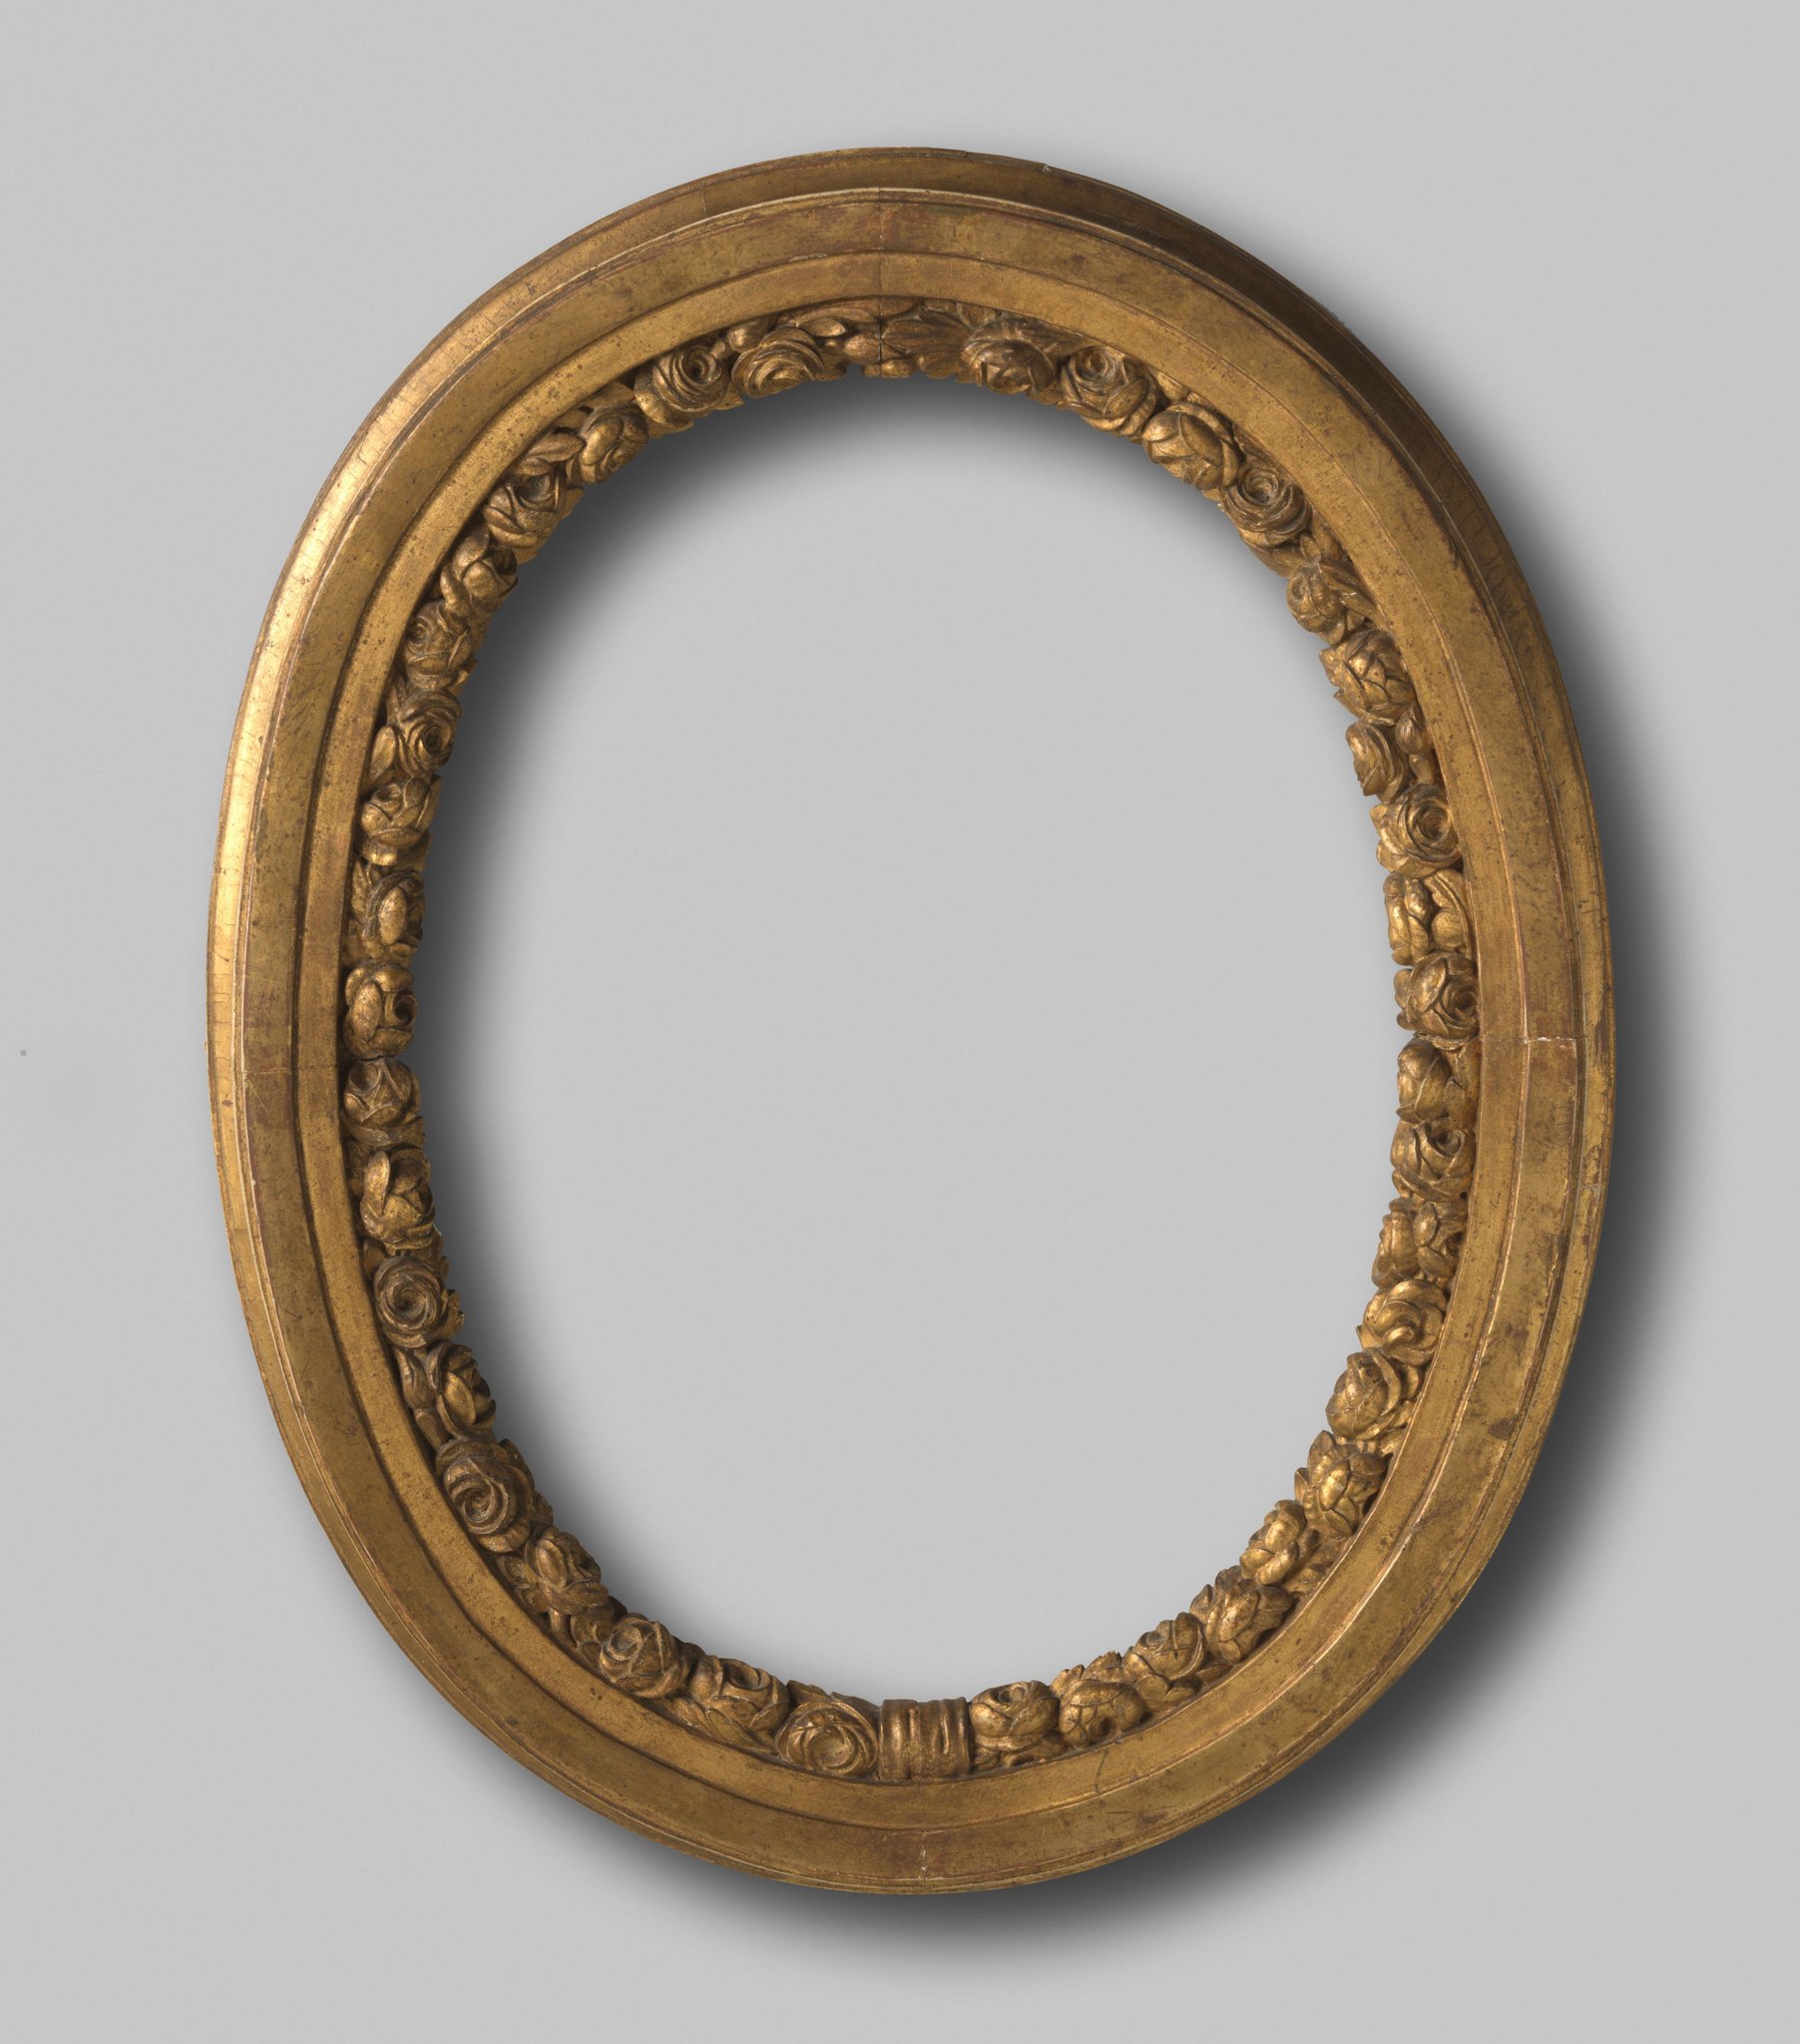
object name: frame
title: Ovale vergulde lijst met gesneden ornamenten aan de dagkant, horend bij relief met het offer aan Venus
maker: louis-simon boizot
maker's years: 1743-1809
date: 1766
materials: gold leaf, wood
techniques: cutting, gilding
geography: rome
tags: veneration of venus, sacrifice ~ roman religion